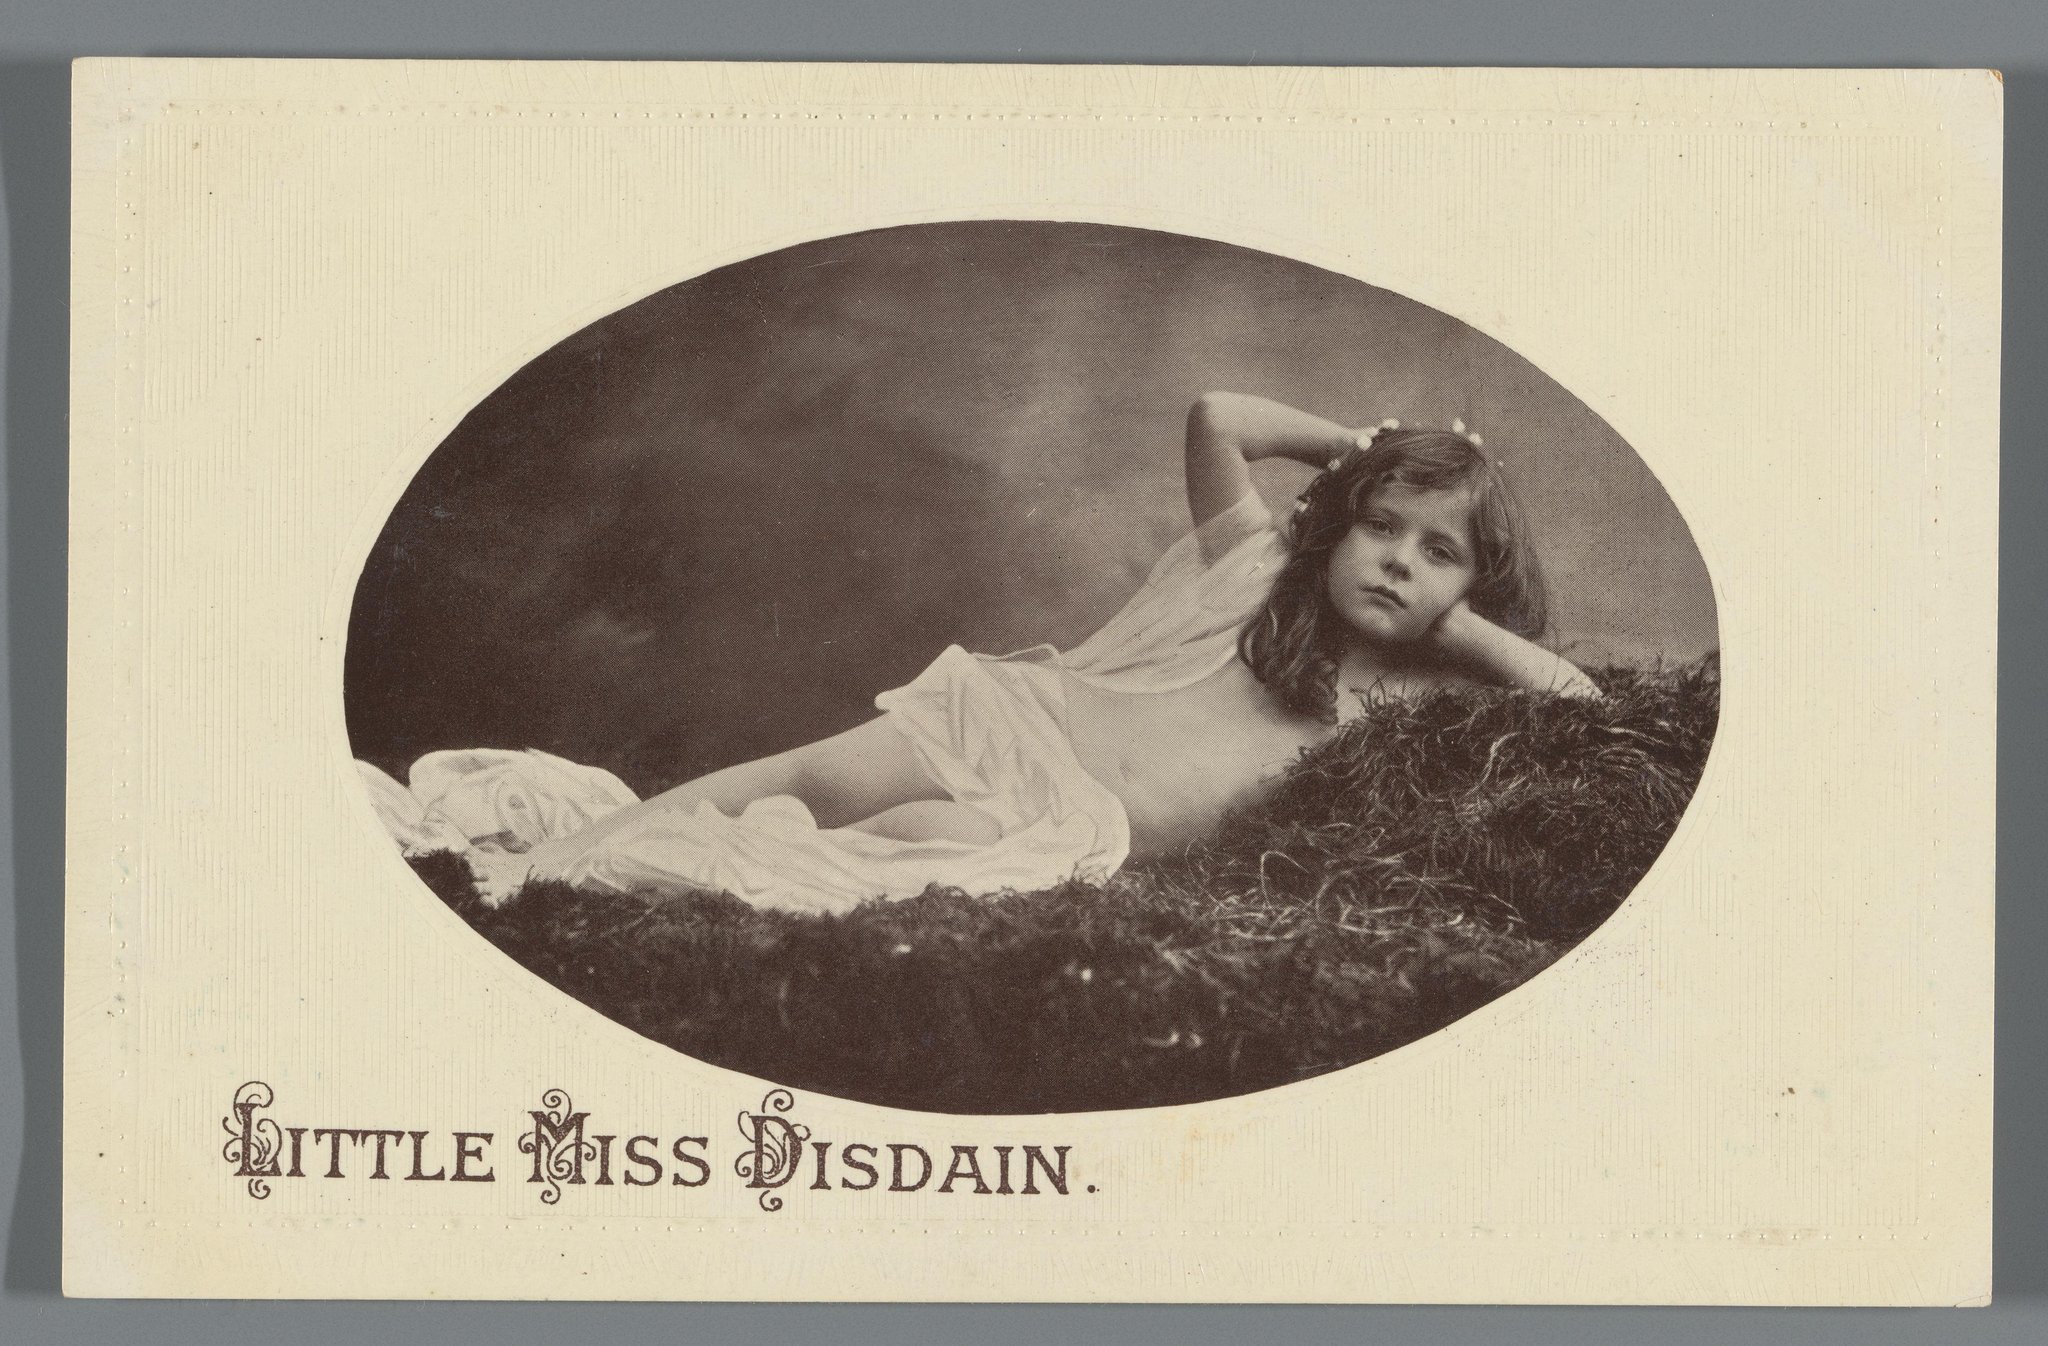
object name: ansichtkaart, prentbriefkaart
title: Liggend meisje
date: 1906-1909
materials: paper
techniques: autotype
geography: london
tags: girl (child between toddler and youth)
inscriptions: inscription: ‘No. 68. Printed in Saxony.’